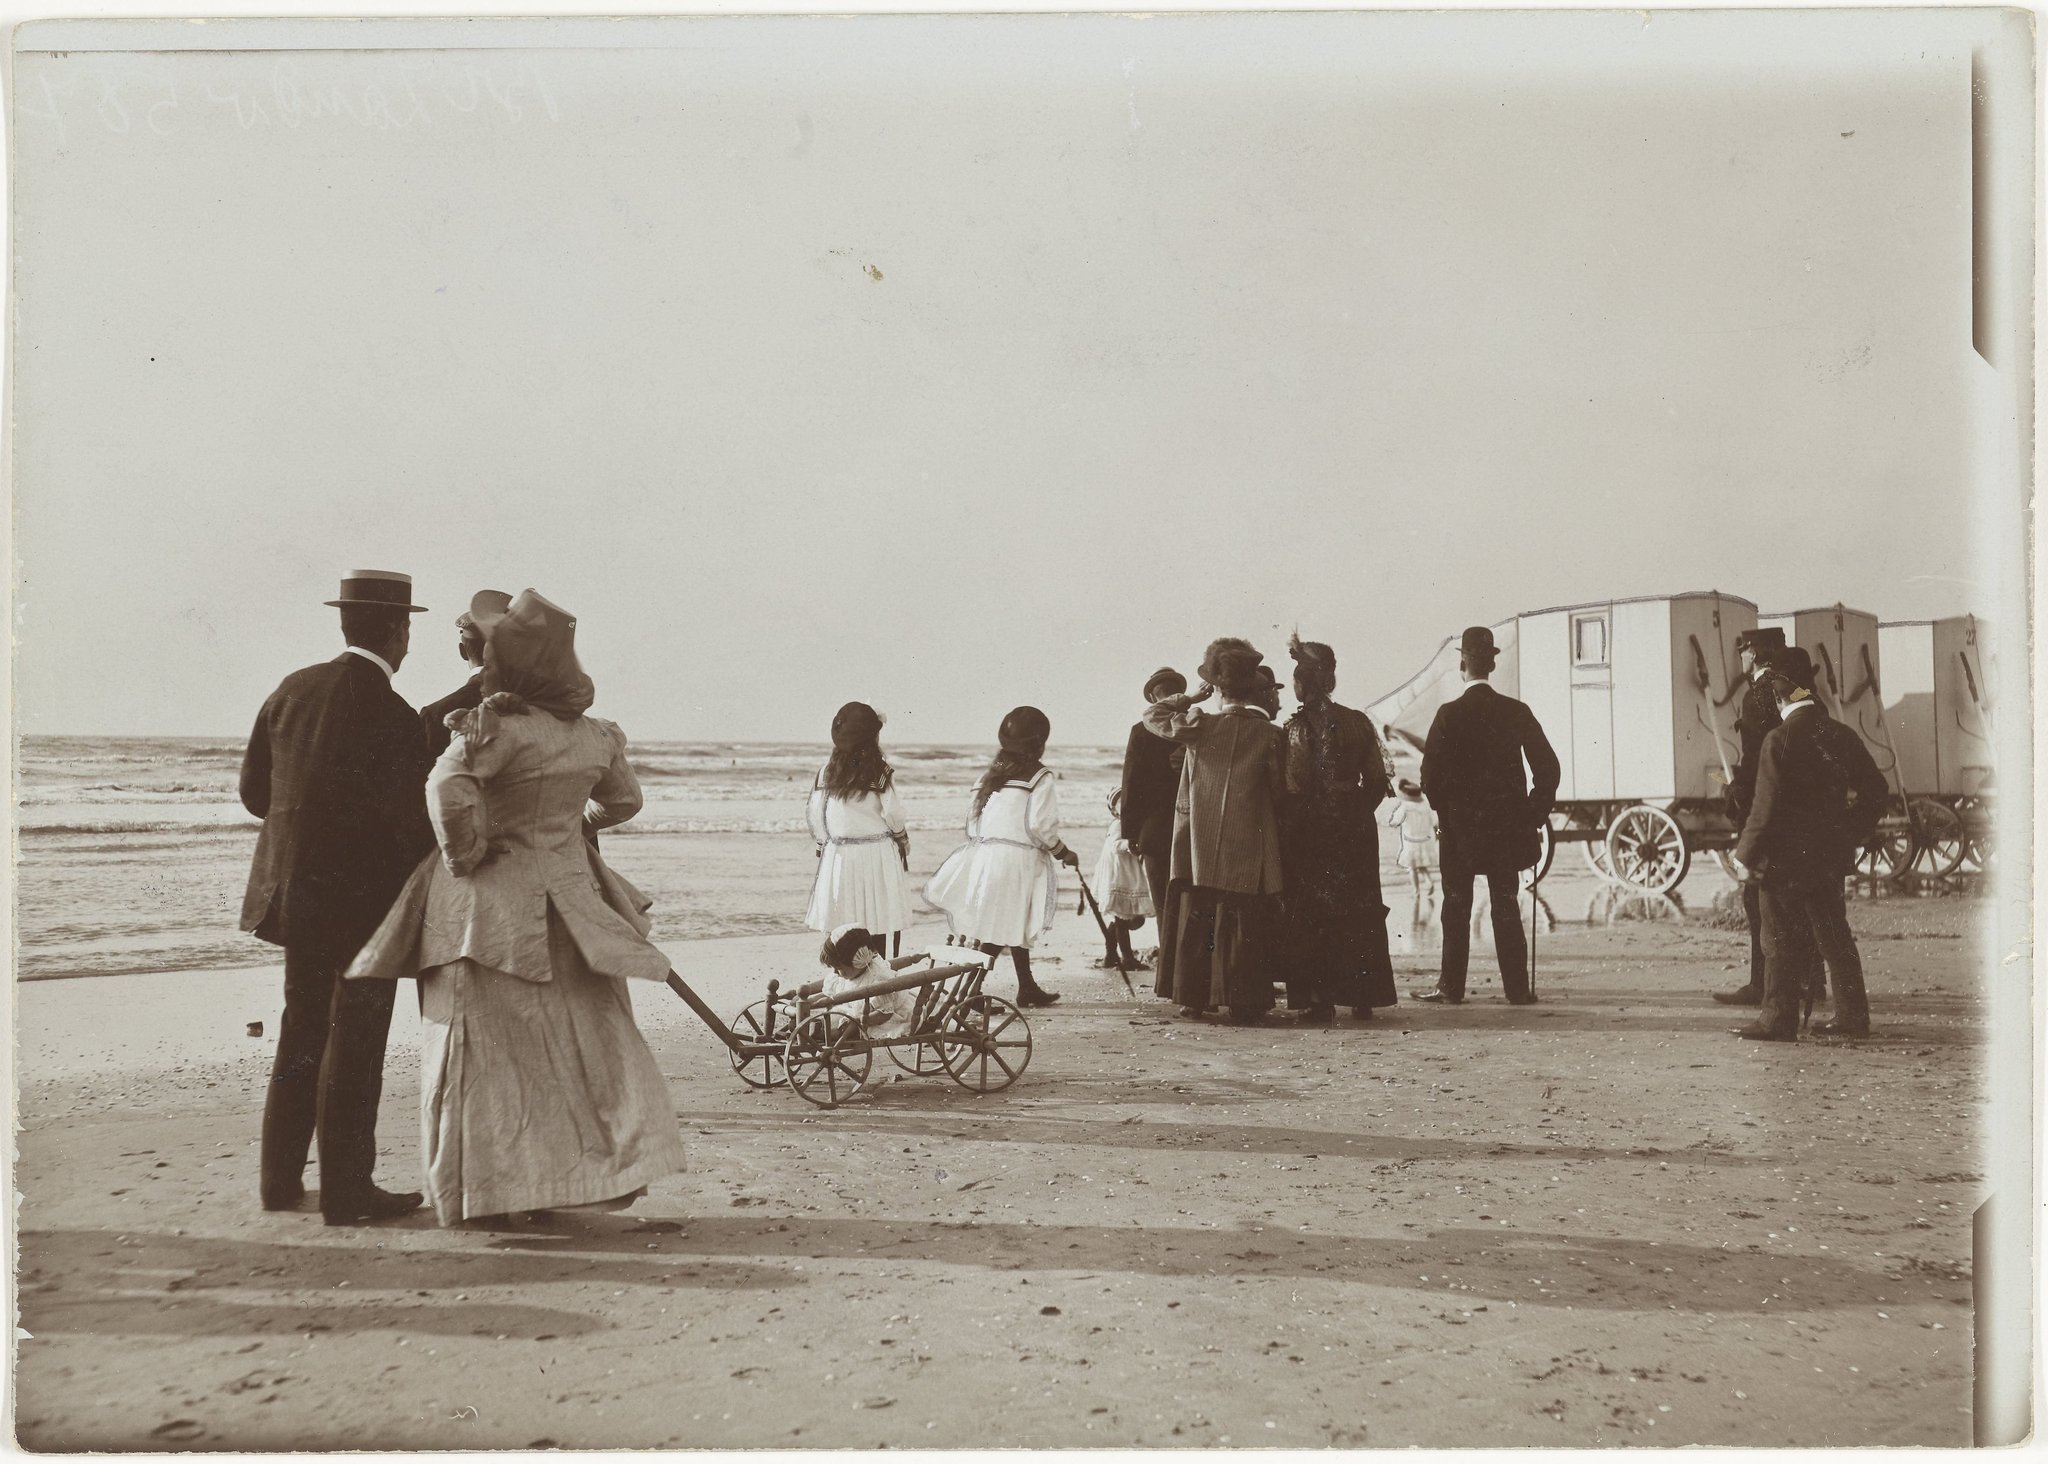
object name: photograph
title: Langs de vloedlijn in Zandvoort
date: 1900-1905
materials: photographic support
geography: zandvoort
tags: beach (as place of recreation)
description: Groepjes wandelaars staan langs de vloedlijn op het strand. Links drie mensen met een kind in een bolderkar. Rechts daarvan een groepje dames en heren met kinderen voor een paar badhokjes op wielen.